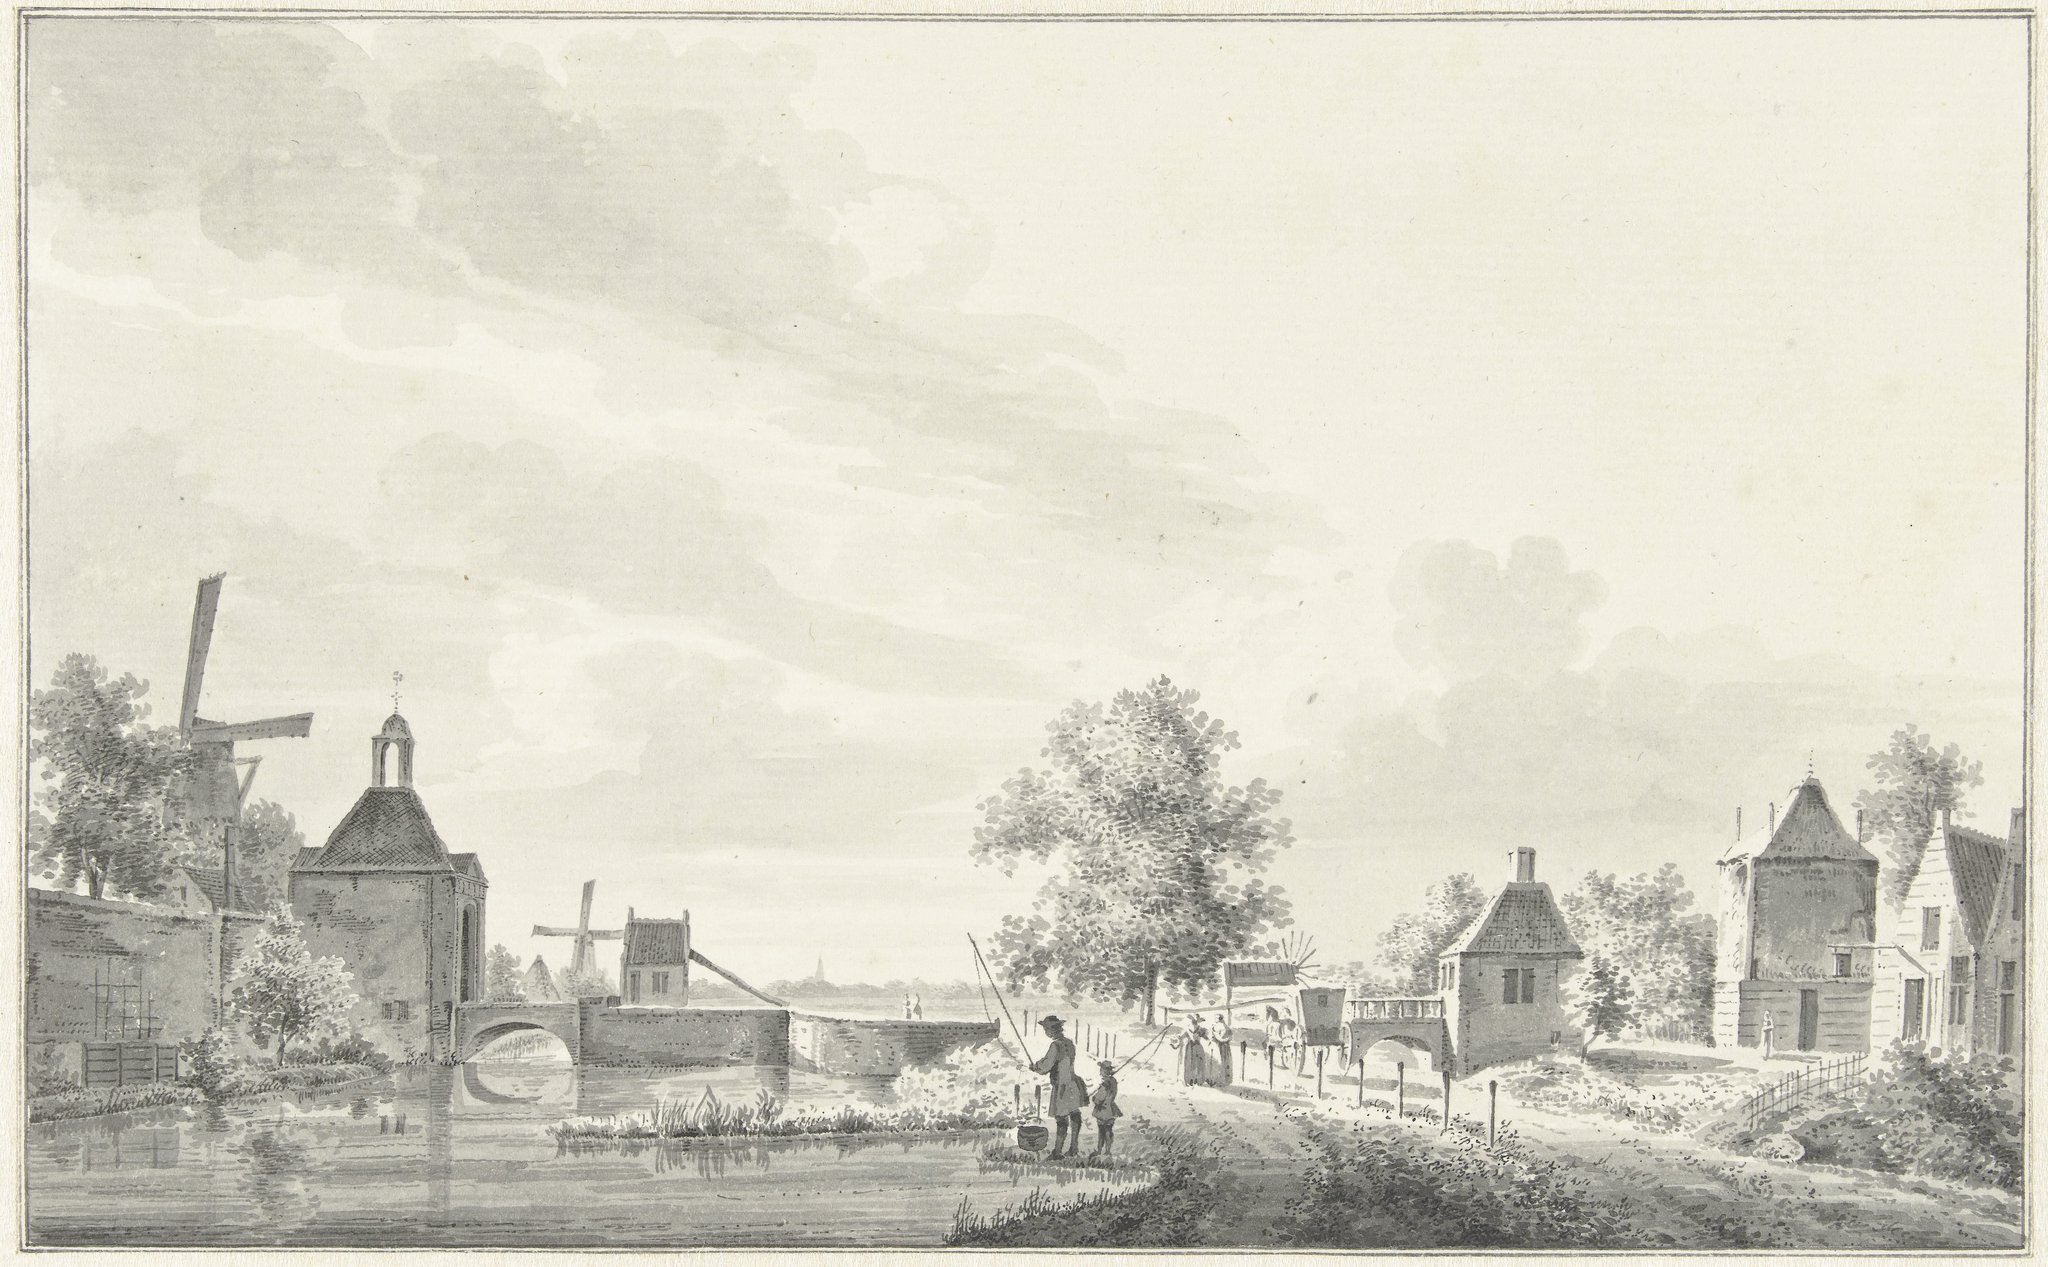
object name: drawing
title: De Benskoper Poort te IJsselstein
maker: pieter jan van liender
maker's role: print maker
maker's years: 1727-1779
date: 1752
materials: ink, paper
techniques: brush, pen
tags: city-gate